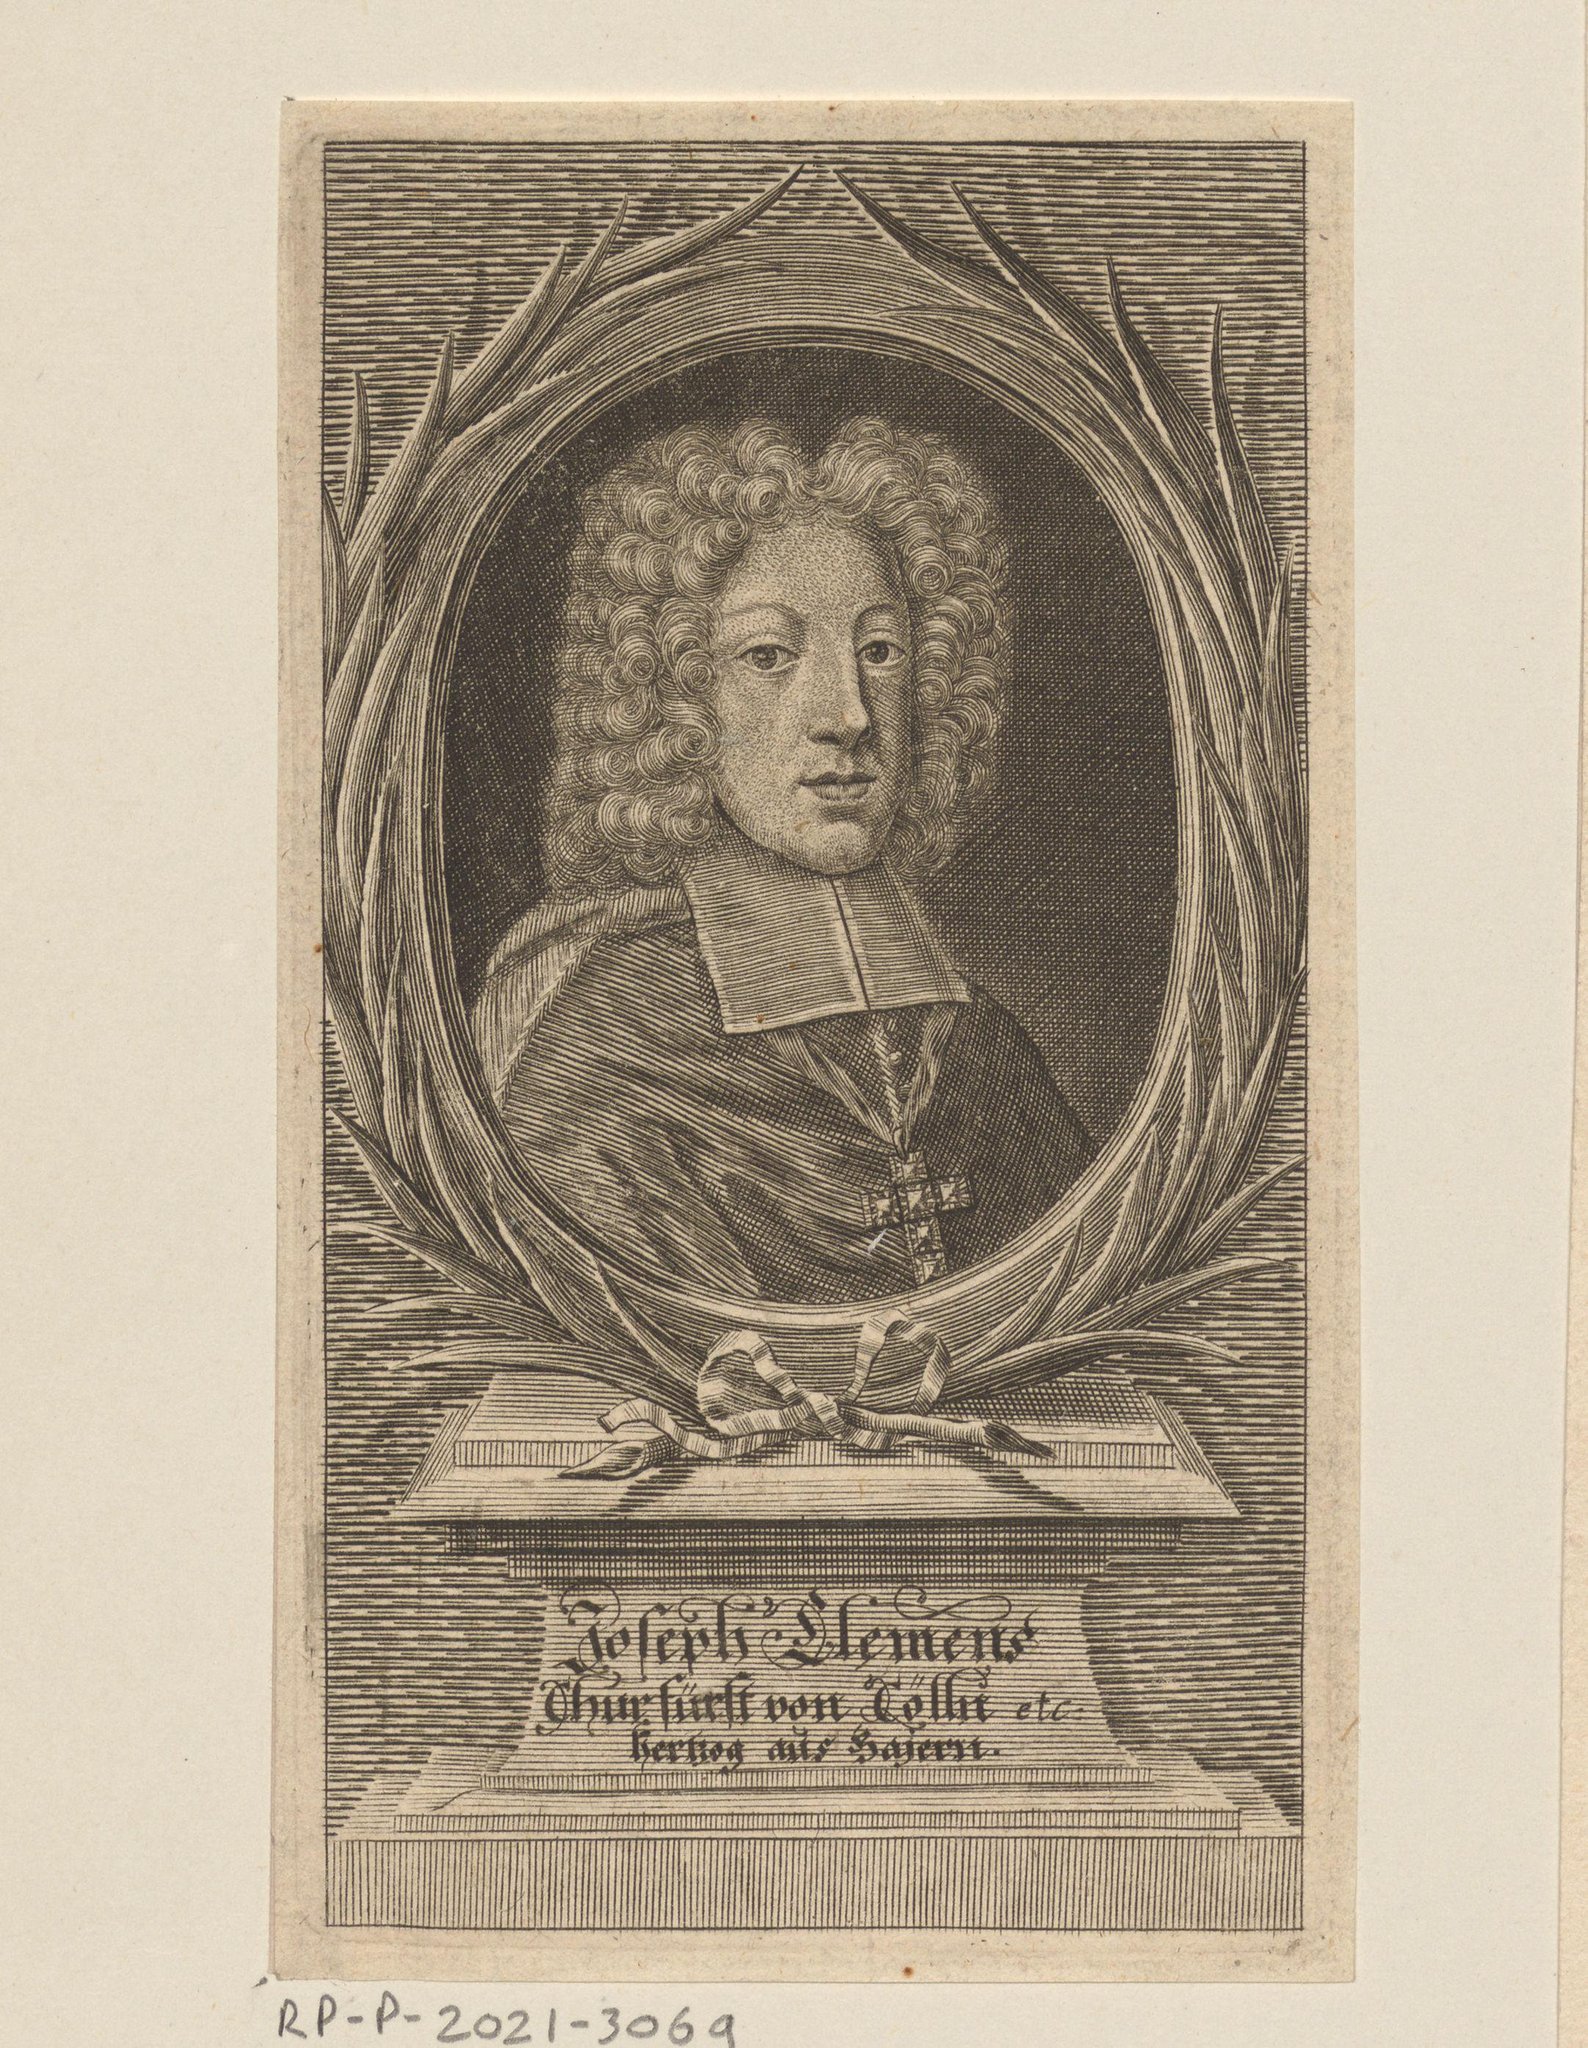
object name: print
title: Portret van Jozef Klemens, keurvorst en aartsbisschop van Keulen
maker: Anonymous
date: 1688-1749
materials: paper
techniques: engraving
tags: priest, archbishop, bishop, etc. (roman catholic), historical persons, ruler, sovereign